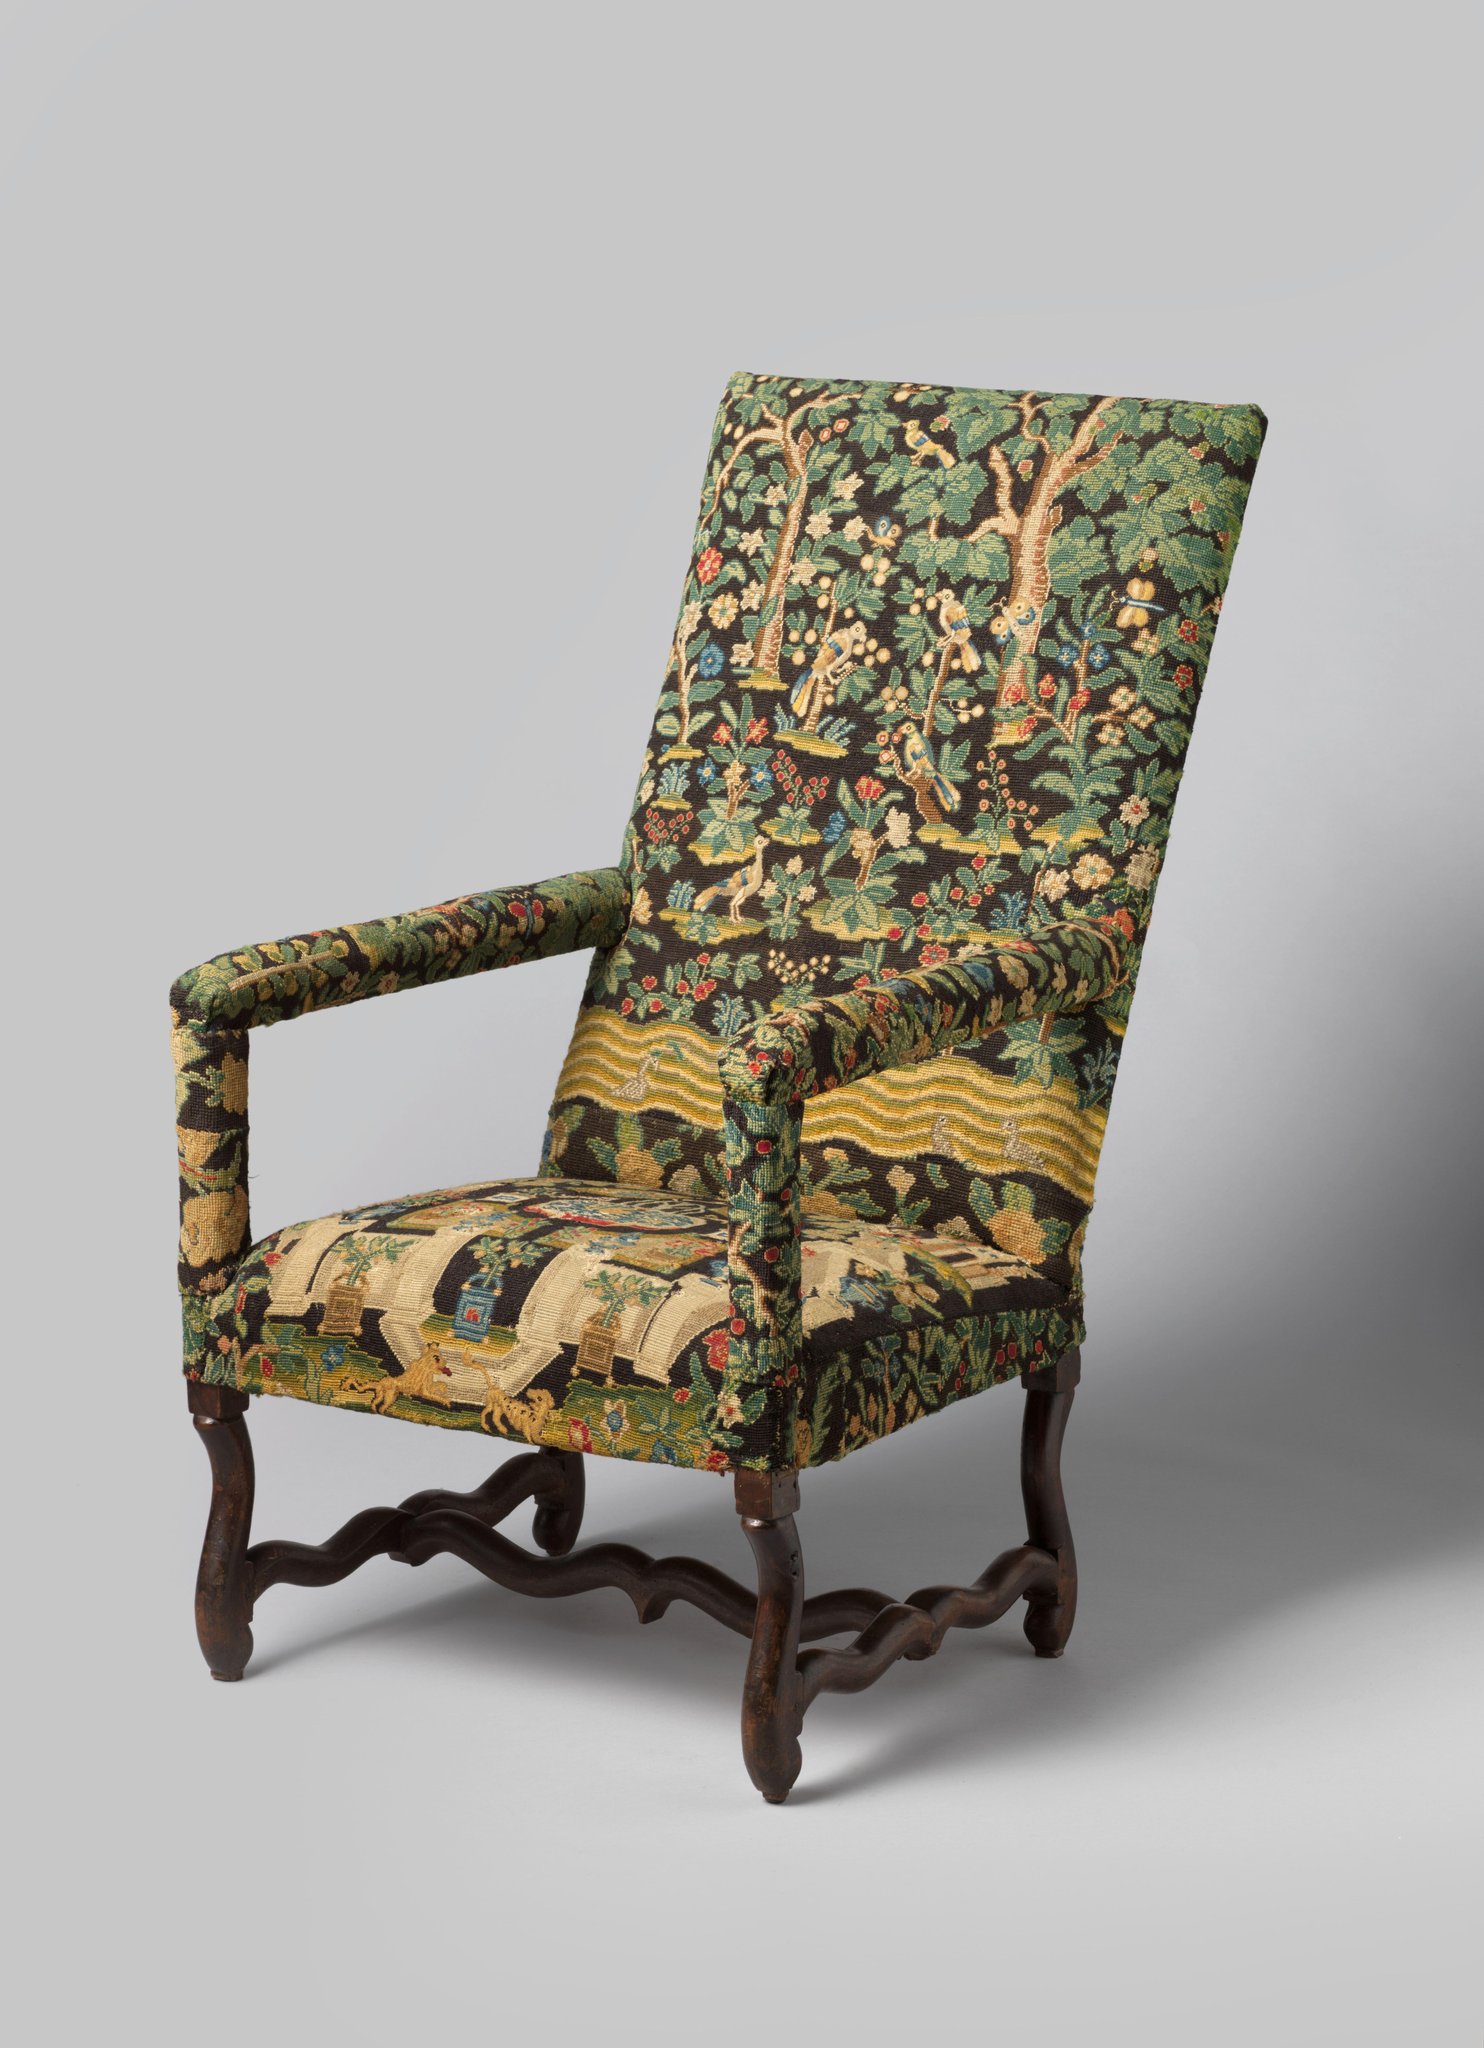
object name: chair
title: Armstoel van notenhout op S-vormige poten, verbonden door H-vormig gegolfd kruis. Bekleed met petit-point.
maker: Anonymous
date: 1650-1700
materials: silk, textile, wood, wool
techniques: embroidered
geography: france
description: Armstoel van notenhout rustend op S-vormige poten, die door een H-vormig gegolfd kruis verbonden zijn. De rechthoekige achterwaarts hellende rug, de rechte armleggers, de armleggerstutten en de zitting zijn allen bekleed met genagelde petit-point.